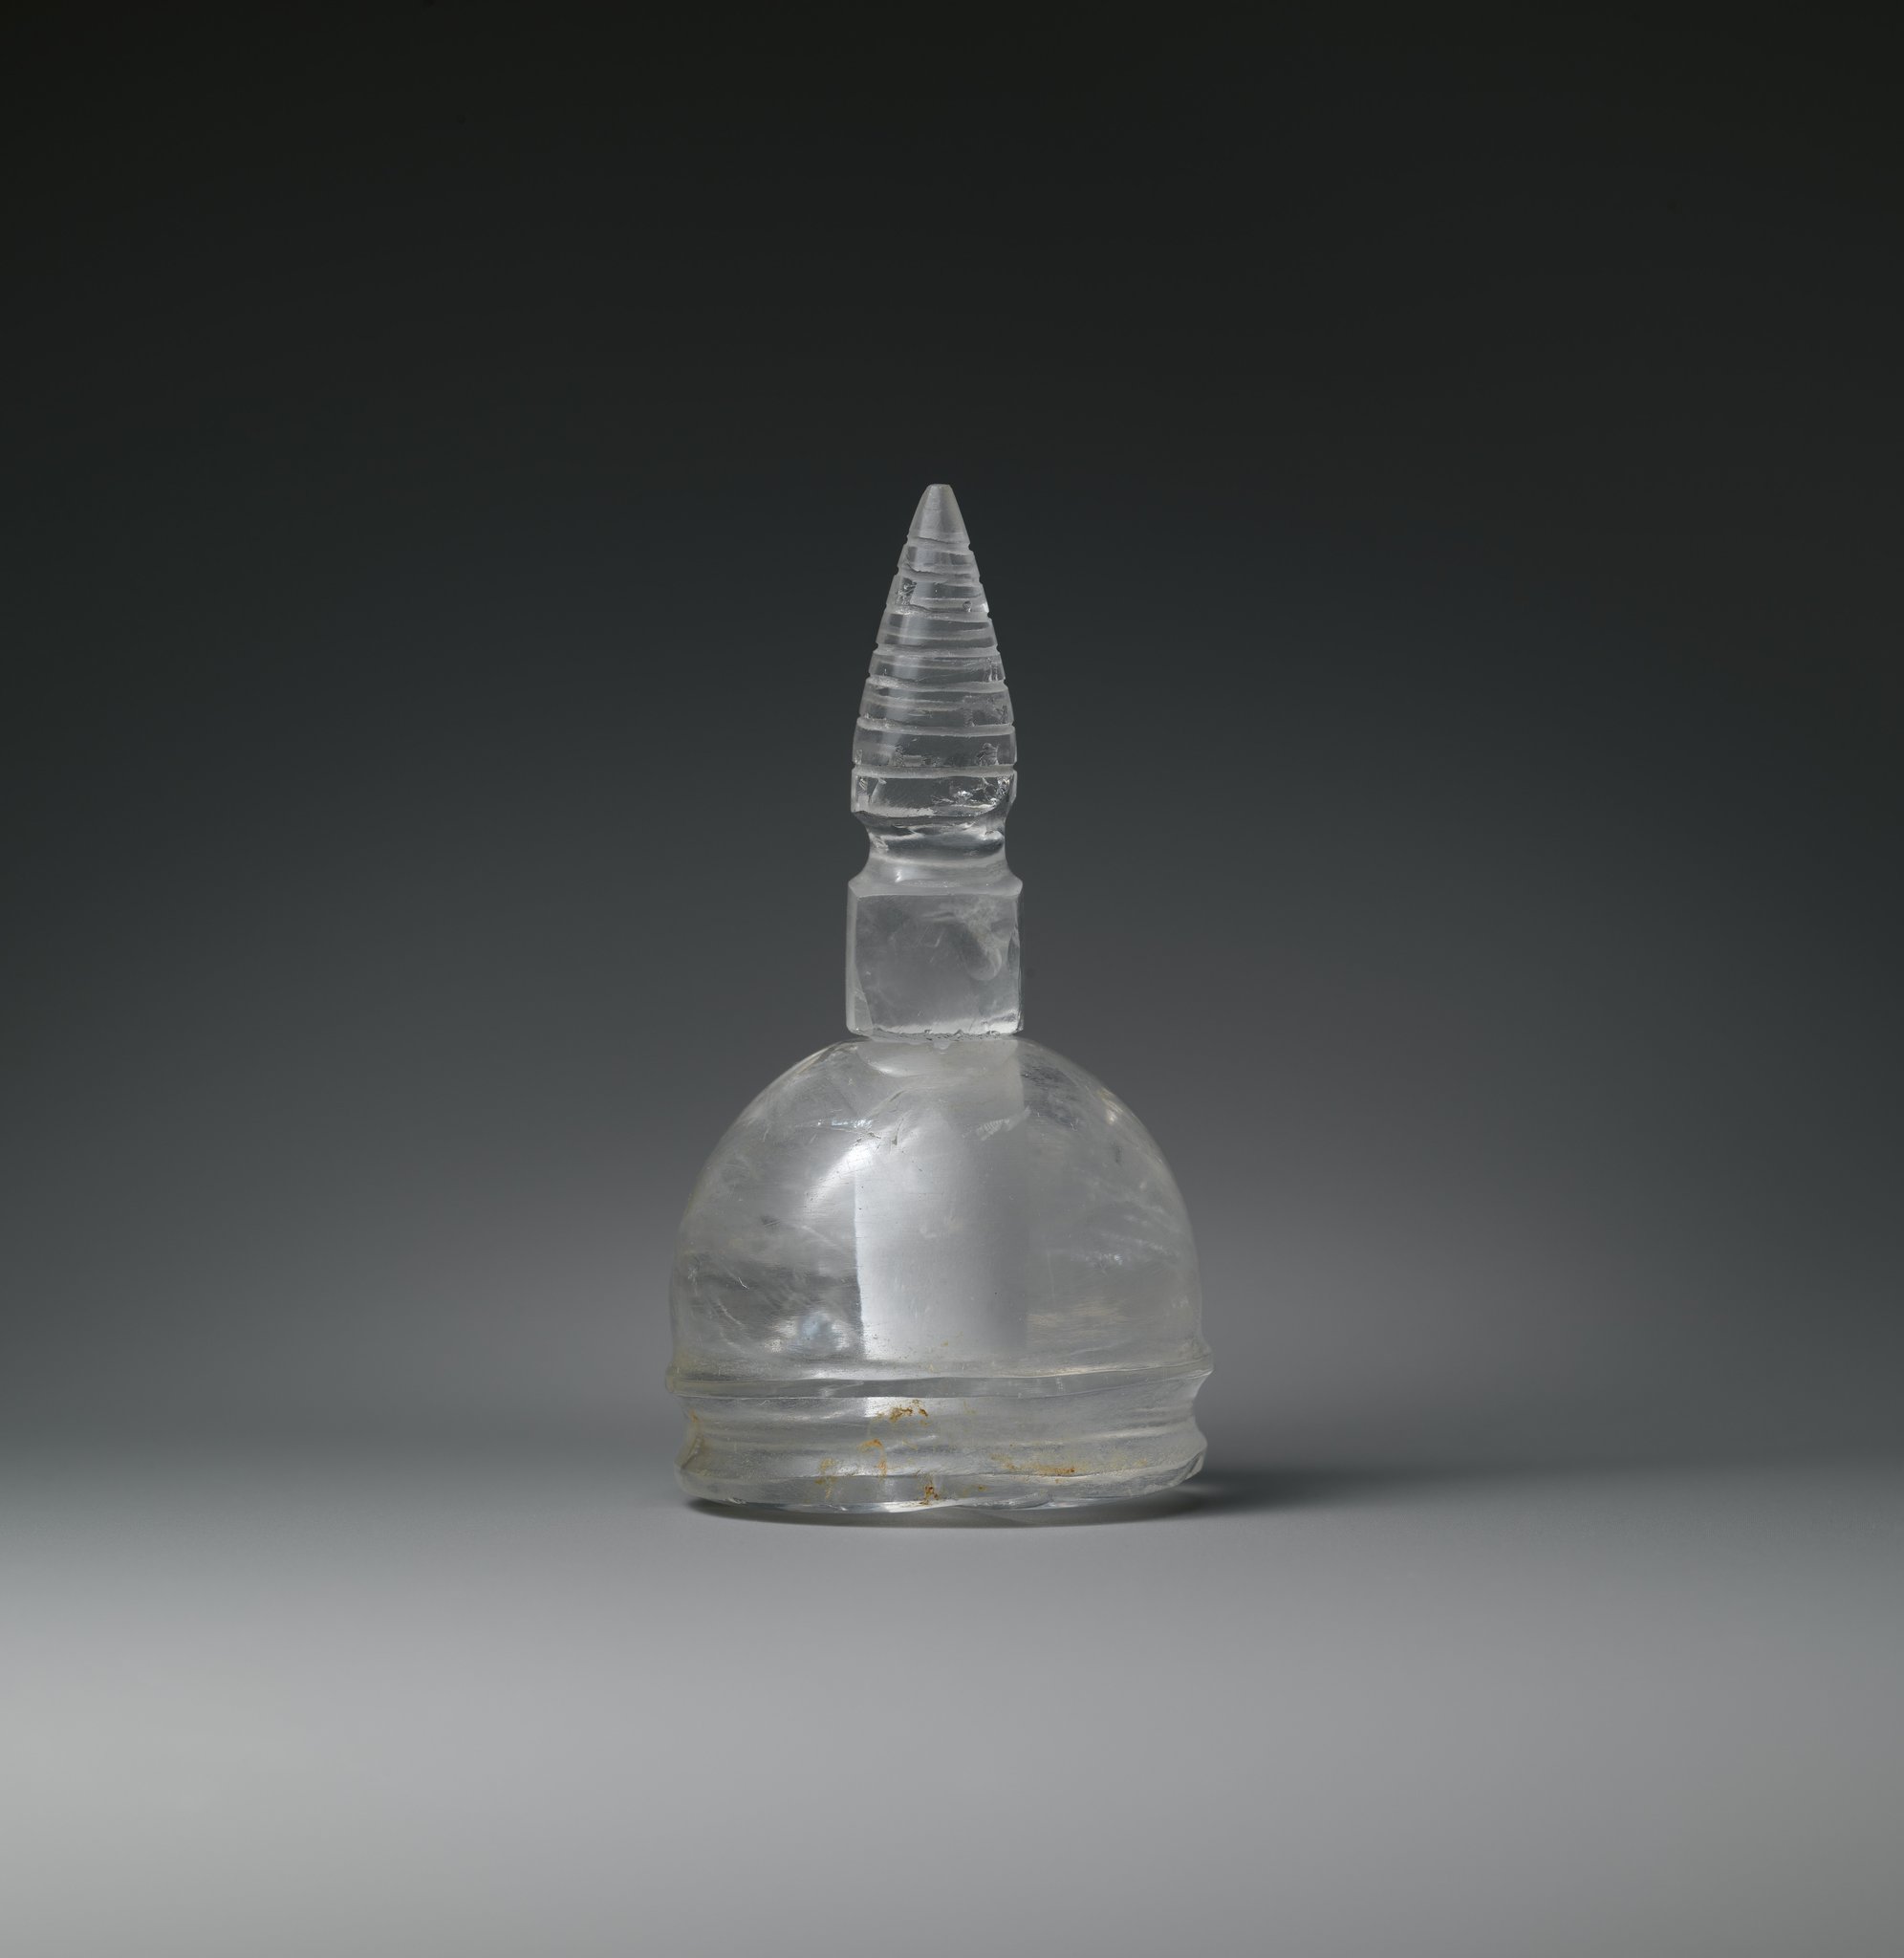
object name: reliquary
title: Reliquary in the shape of a stupa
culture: sri lankan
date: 201-400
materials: quartz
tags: stupas